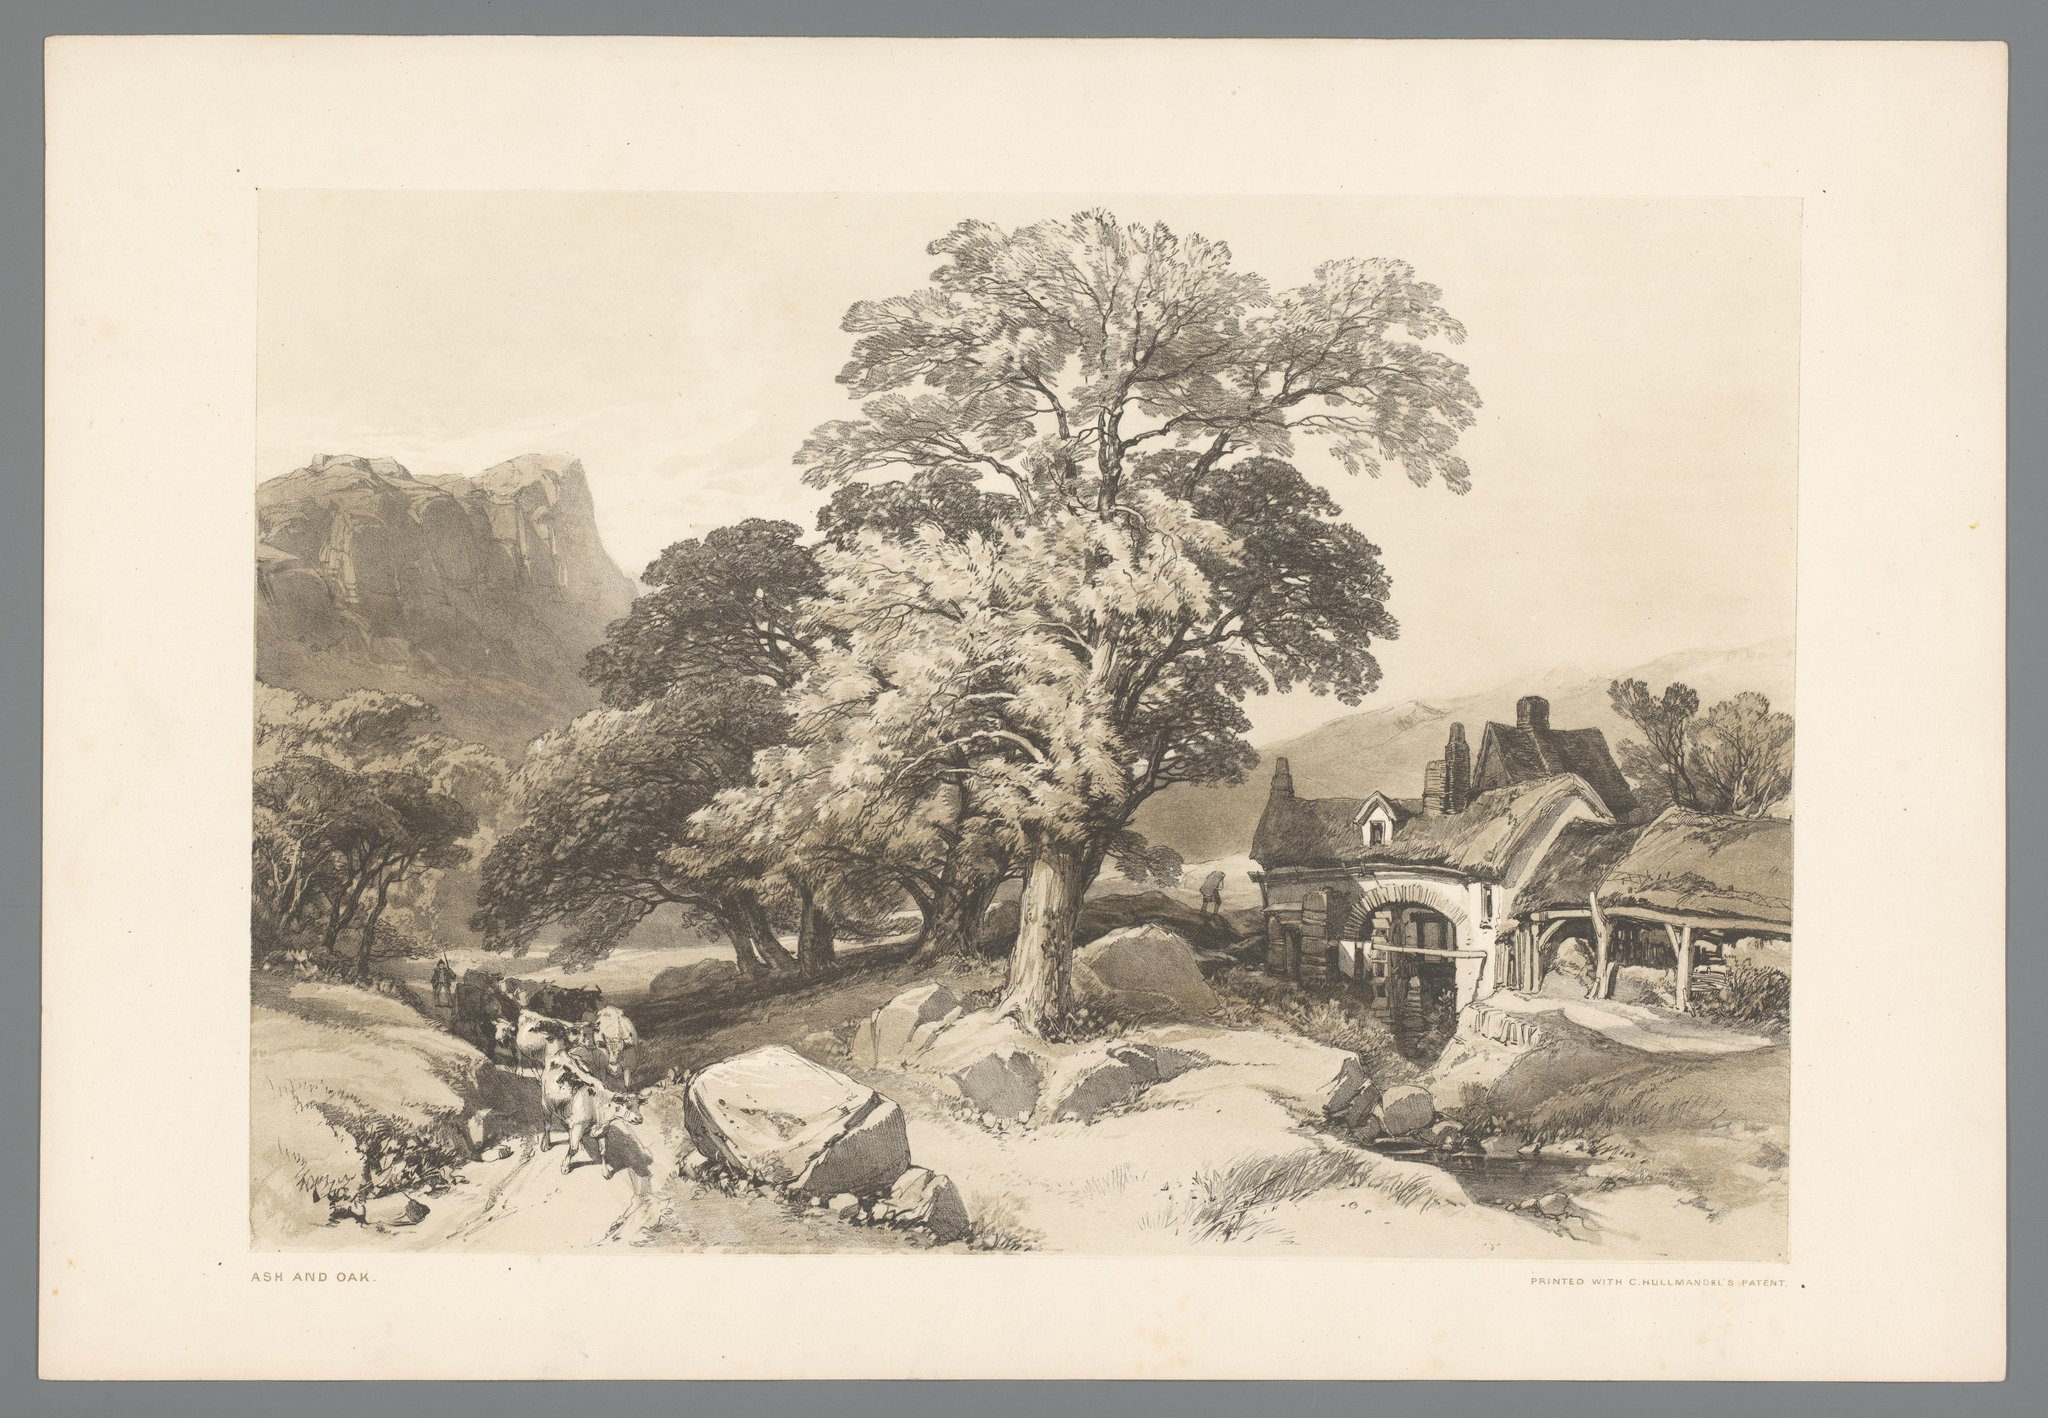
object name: print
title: Plane trees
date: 1841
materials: paper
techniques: tone lithography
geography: london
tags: park, forest, wood, bovine cattle, watermill in landscape (+ city(-scape) with figures, staffage)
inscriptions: collector's mark: Lugt 2228, collector's mark: Lugt 2760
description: Prent maakt deel uit van een serie van 24 prenten.